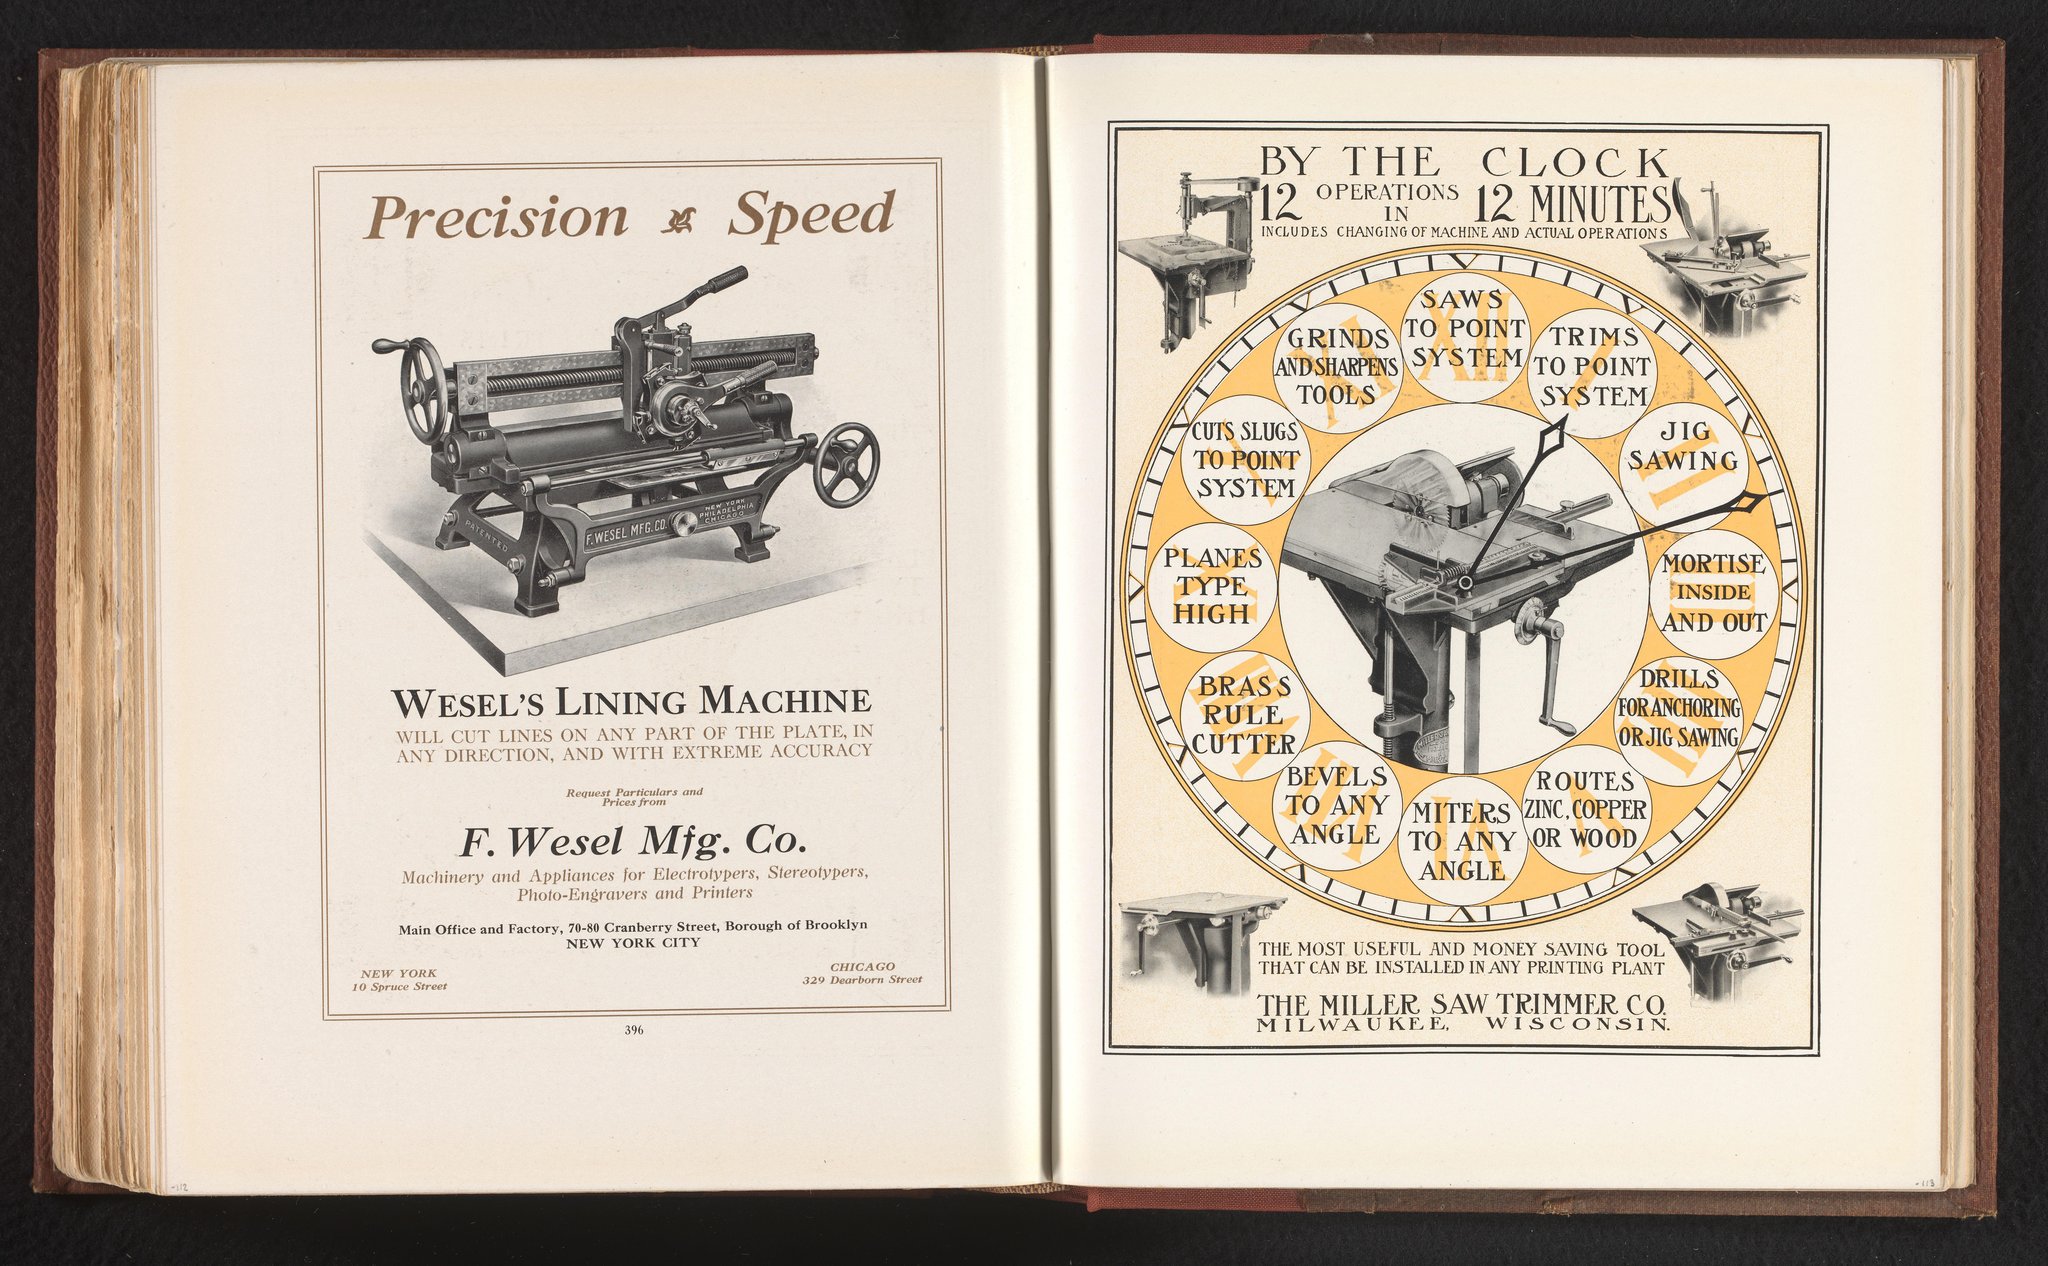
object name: photomechanical print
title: Precision & Speed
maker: Anonymous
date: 1904-1909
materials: paper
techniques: autotype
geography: new york city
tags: advertising, tools, implements of printer